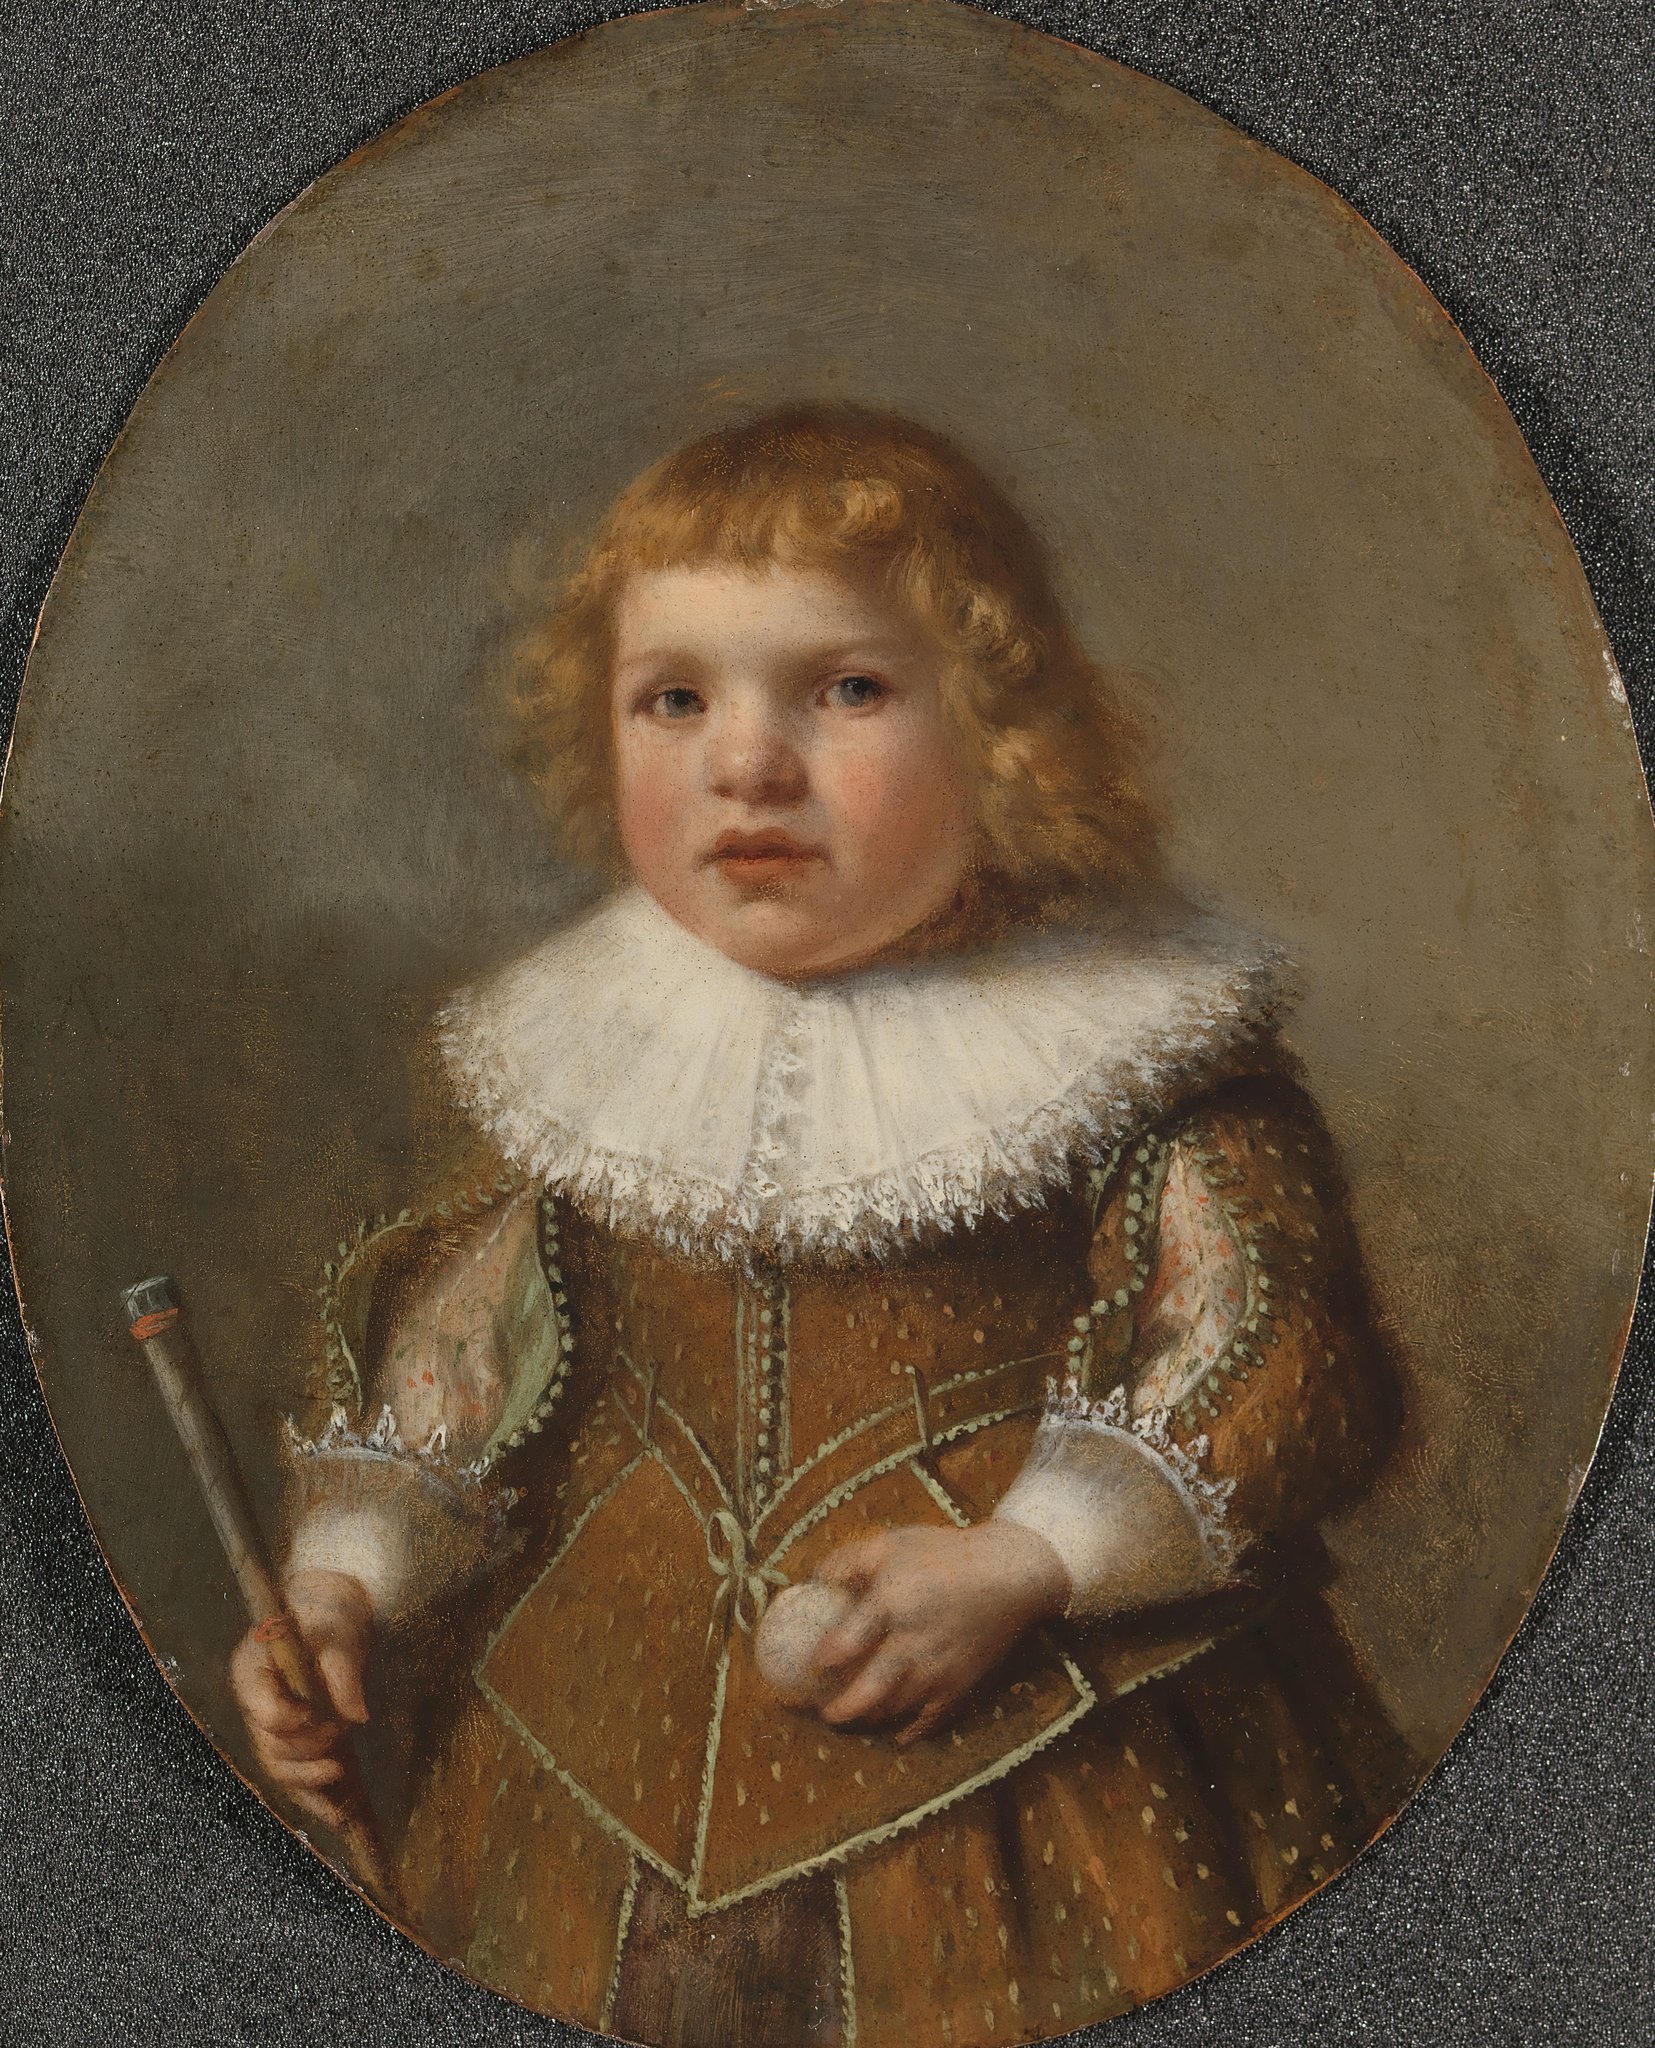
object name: painting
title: Portrait of Samuel Cornelisz van Esch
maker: Anonymous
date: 1632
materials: copper, oil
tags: historical persons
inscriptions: inscription, centre left: ‘ÆT[...]’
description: Portret van Samuel, zoon van Cornelis Samuelsz. van Esch en Josina Jansdr. de Carpentier. Ten halven lijve, iets naar links, een appel in de linkerhand, in de rechterhand een fluit of een stok. Onderdeel van een serie van zeven ovale portretten van Cornelis Samuelsz van Esch, zijn vrouw Josina Jansdr de Carpentier, hun drie dochtertjes en twee zoontjes (SK-A-1747-A/G).